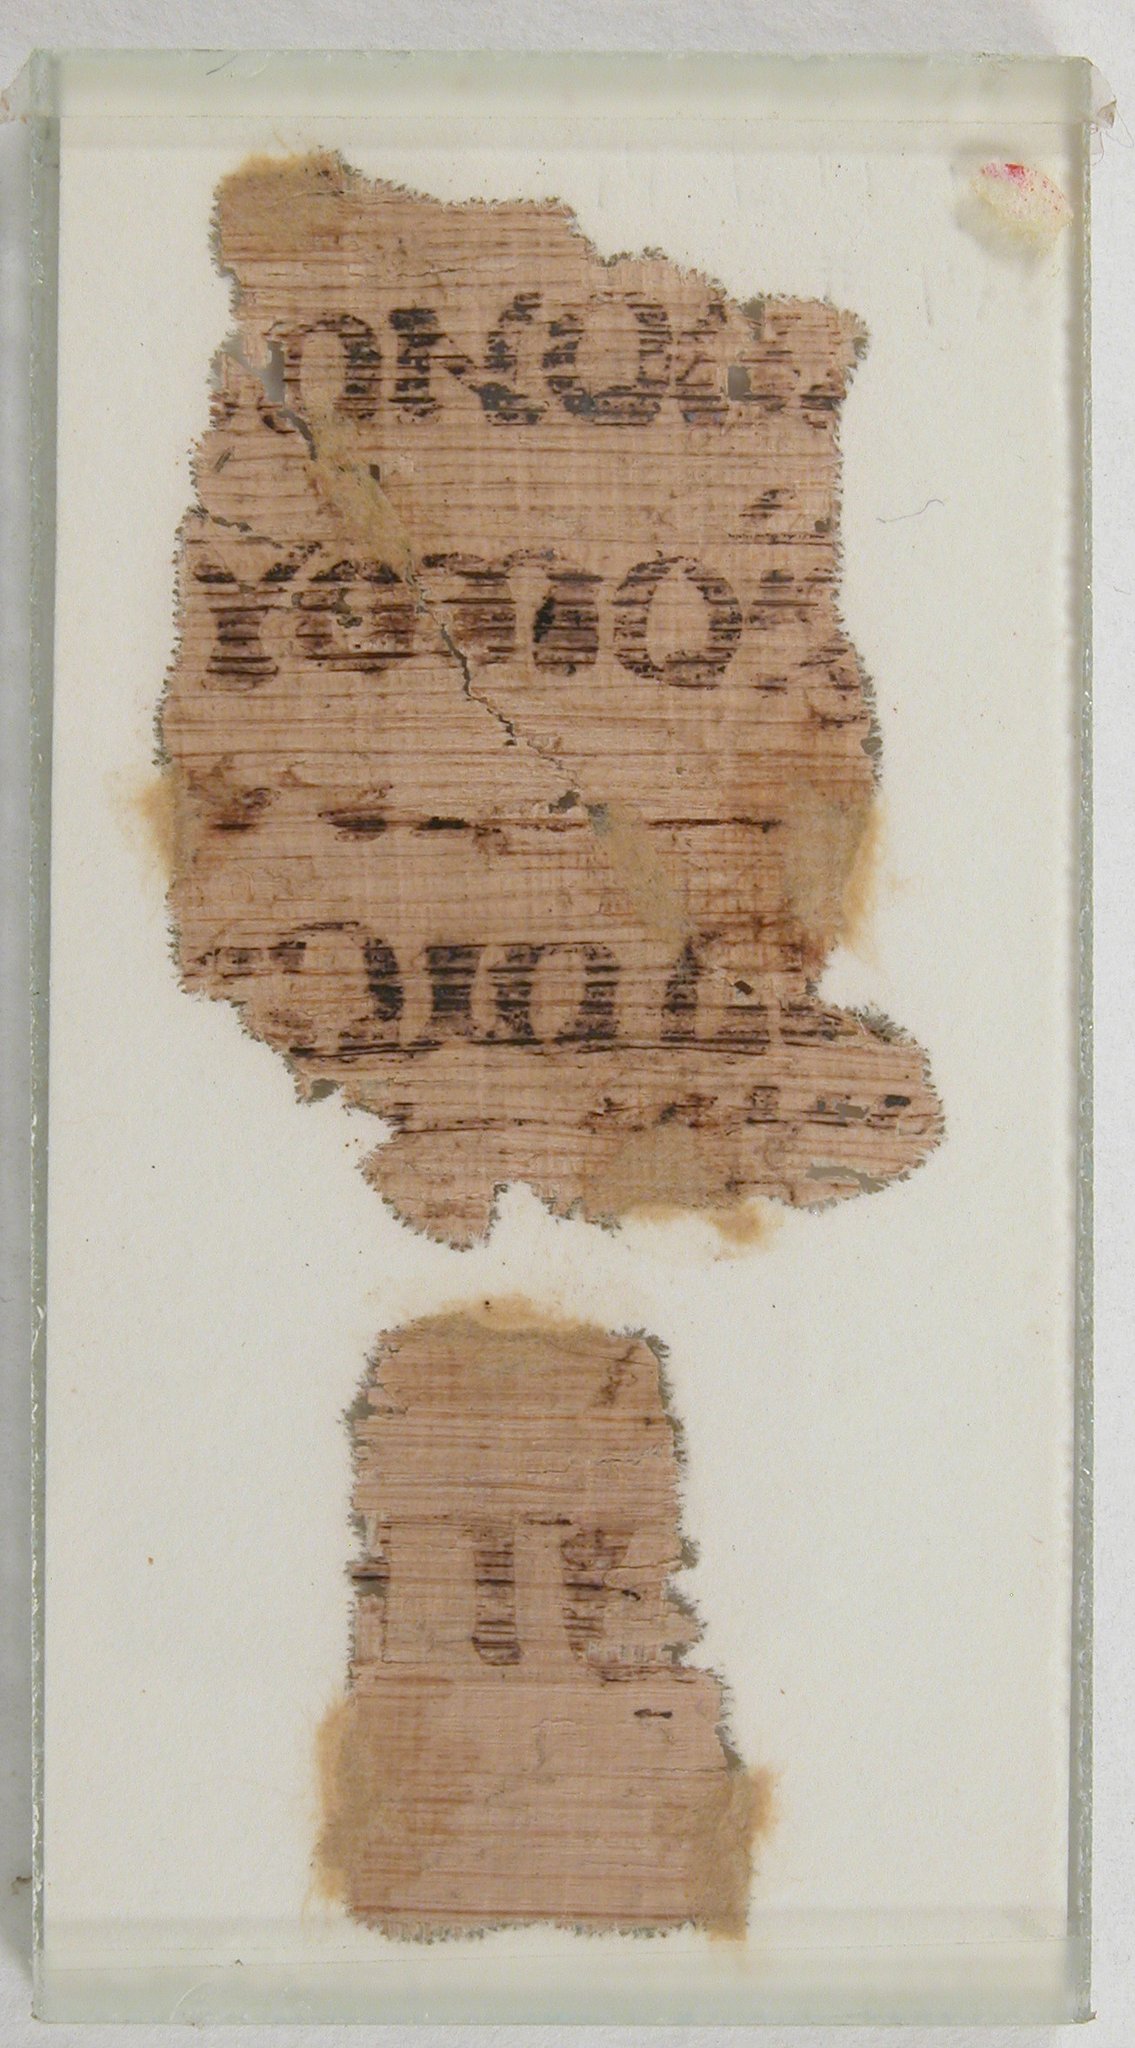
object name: fragment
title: Papyrus Fragment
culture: coptic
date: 601-700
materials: ink, papyrus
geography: egypt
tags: coptic,documents